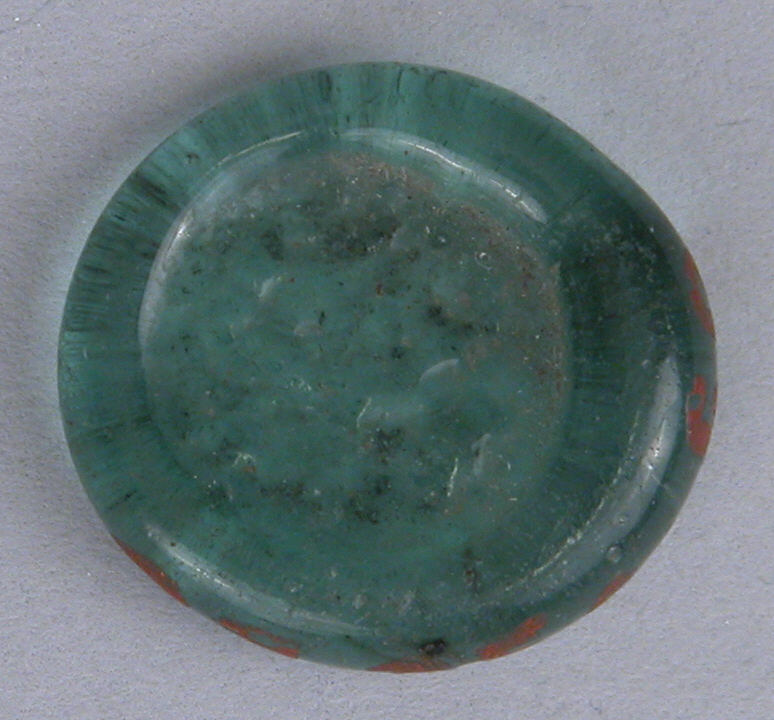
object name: coin weight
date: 901-1200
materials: glass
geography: egypt